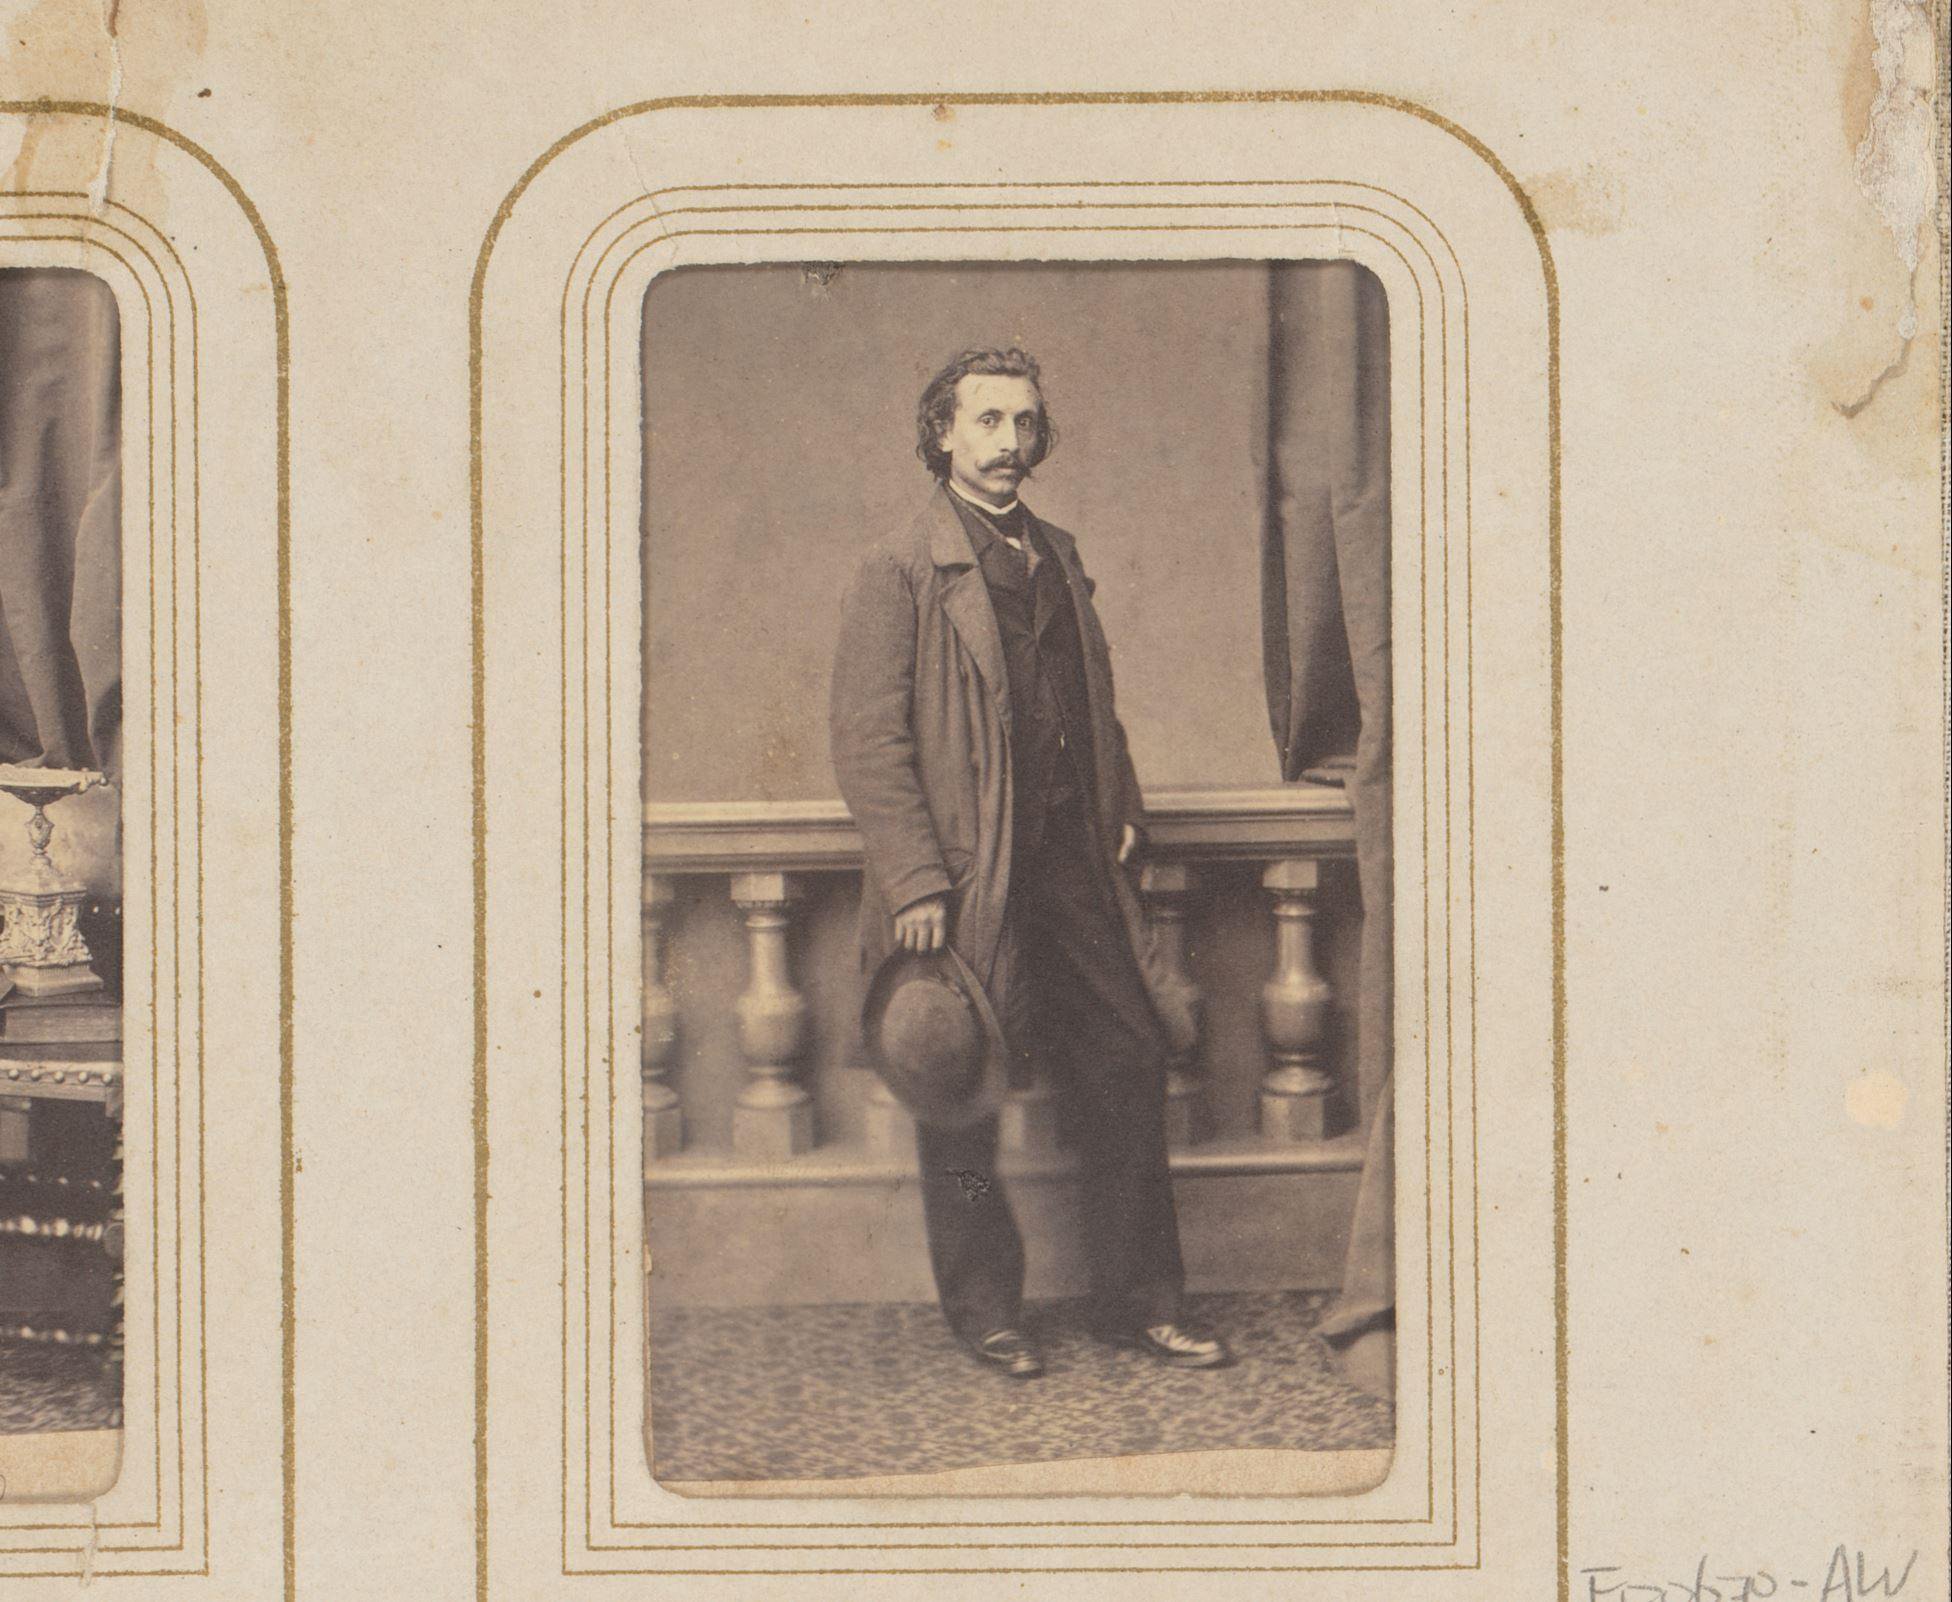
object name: album leaf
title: Portret van Lambert Herman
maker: Anonymous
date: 1861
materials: cardboard, photographic support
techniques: albumen print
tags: liège, sculptor, portrait, self-portrait of sculptor, historical persons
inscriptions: annotation: ‘Lambert Herman artiste/ sculpteur 1861’, annotation: ‘Lambert Herman, beeldhouwer’